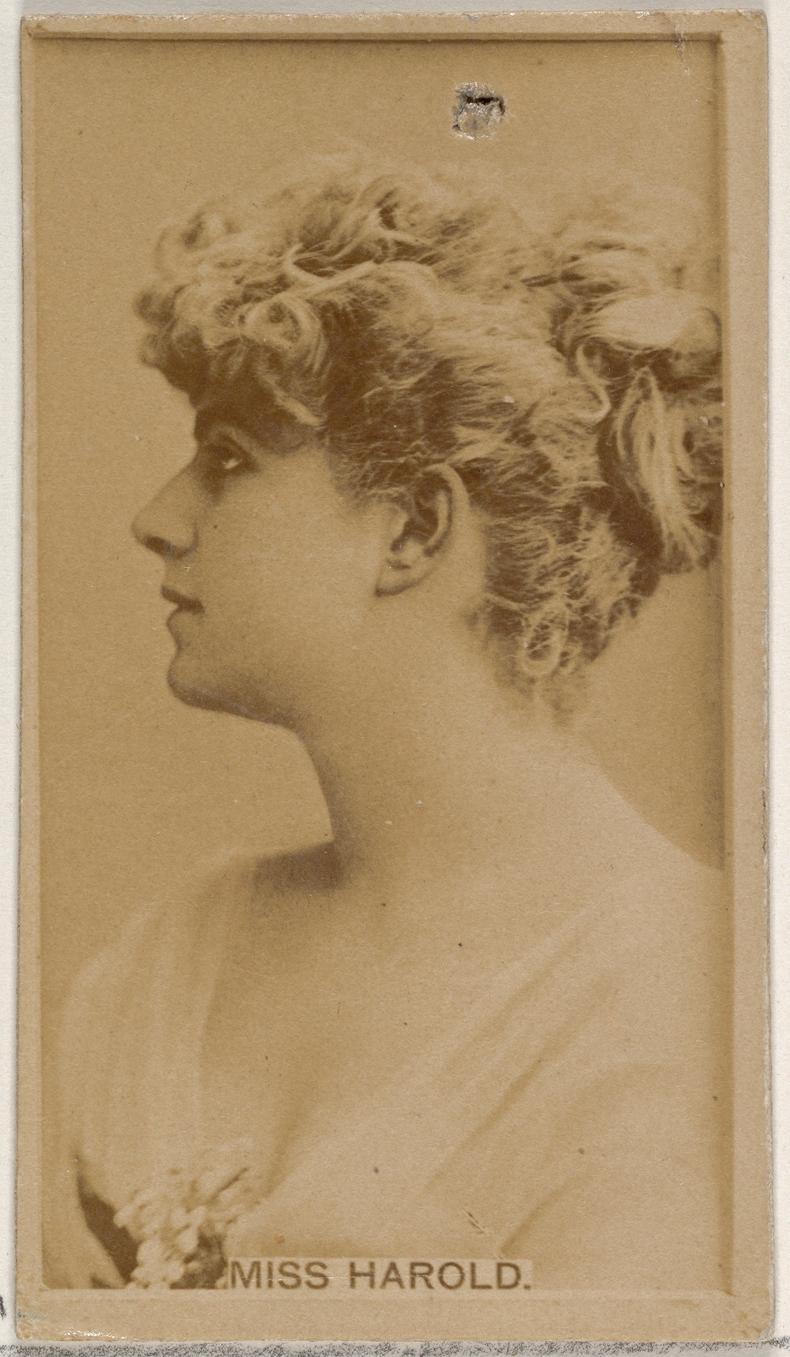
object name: photograph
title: Miss Harold, from the Actors and Actresses series (N45, Type 8) for Virginia Brights Cigarettes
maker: allen & ginter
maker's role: publisher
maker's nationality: american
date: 1888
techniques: albumen silver print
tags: women,actresses